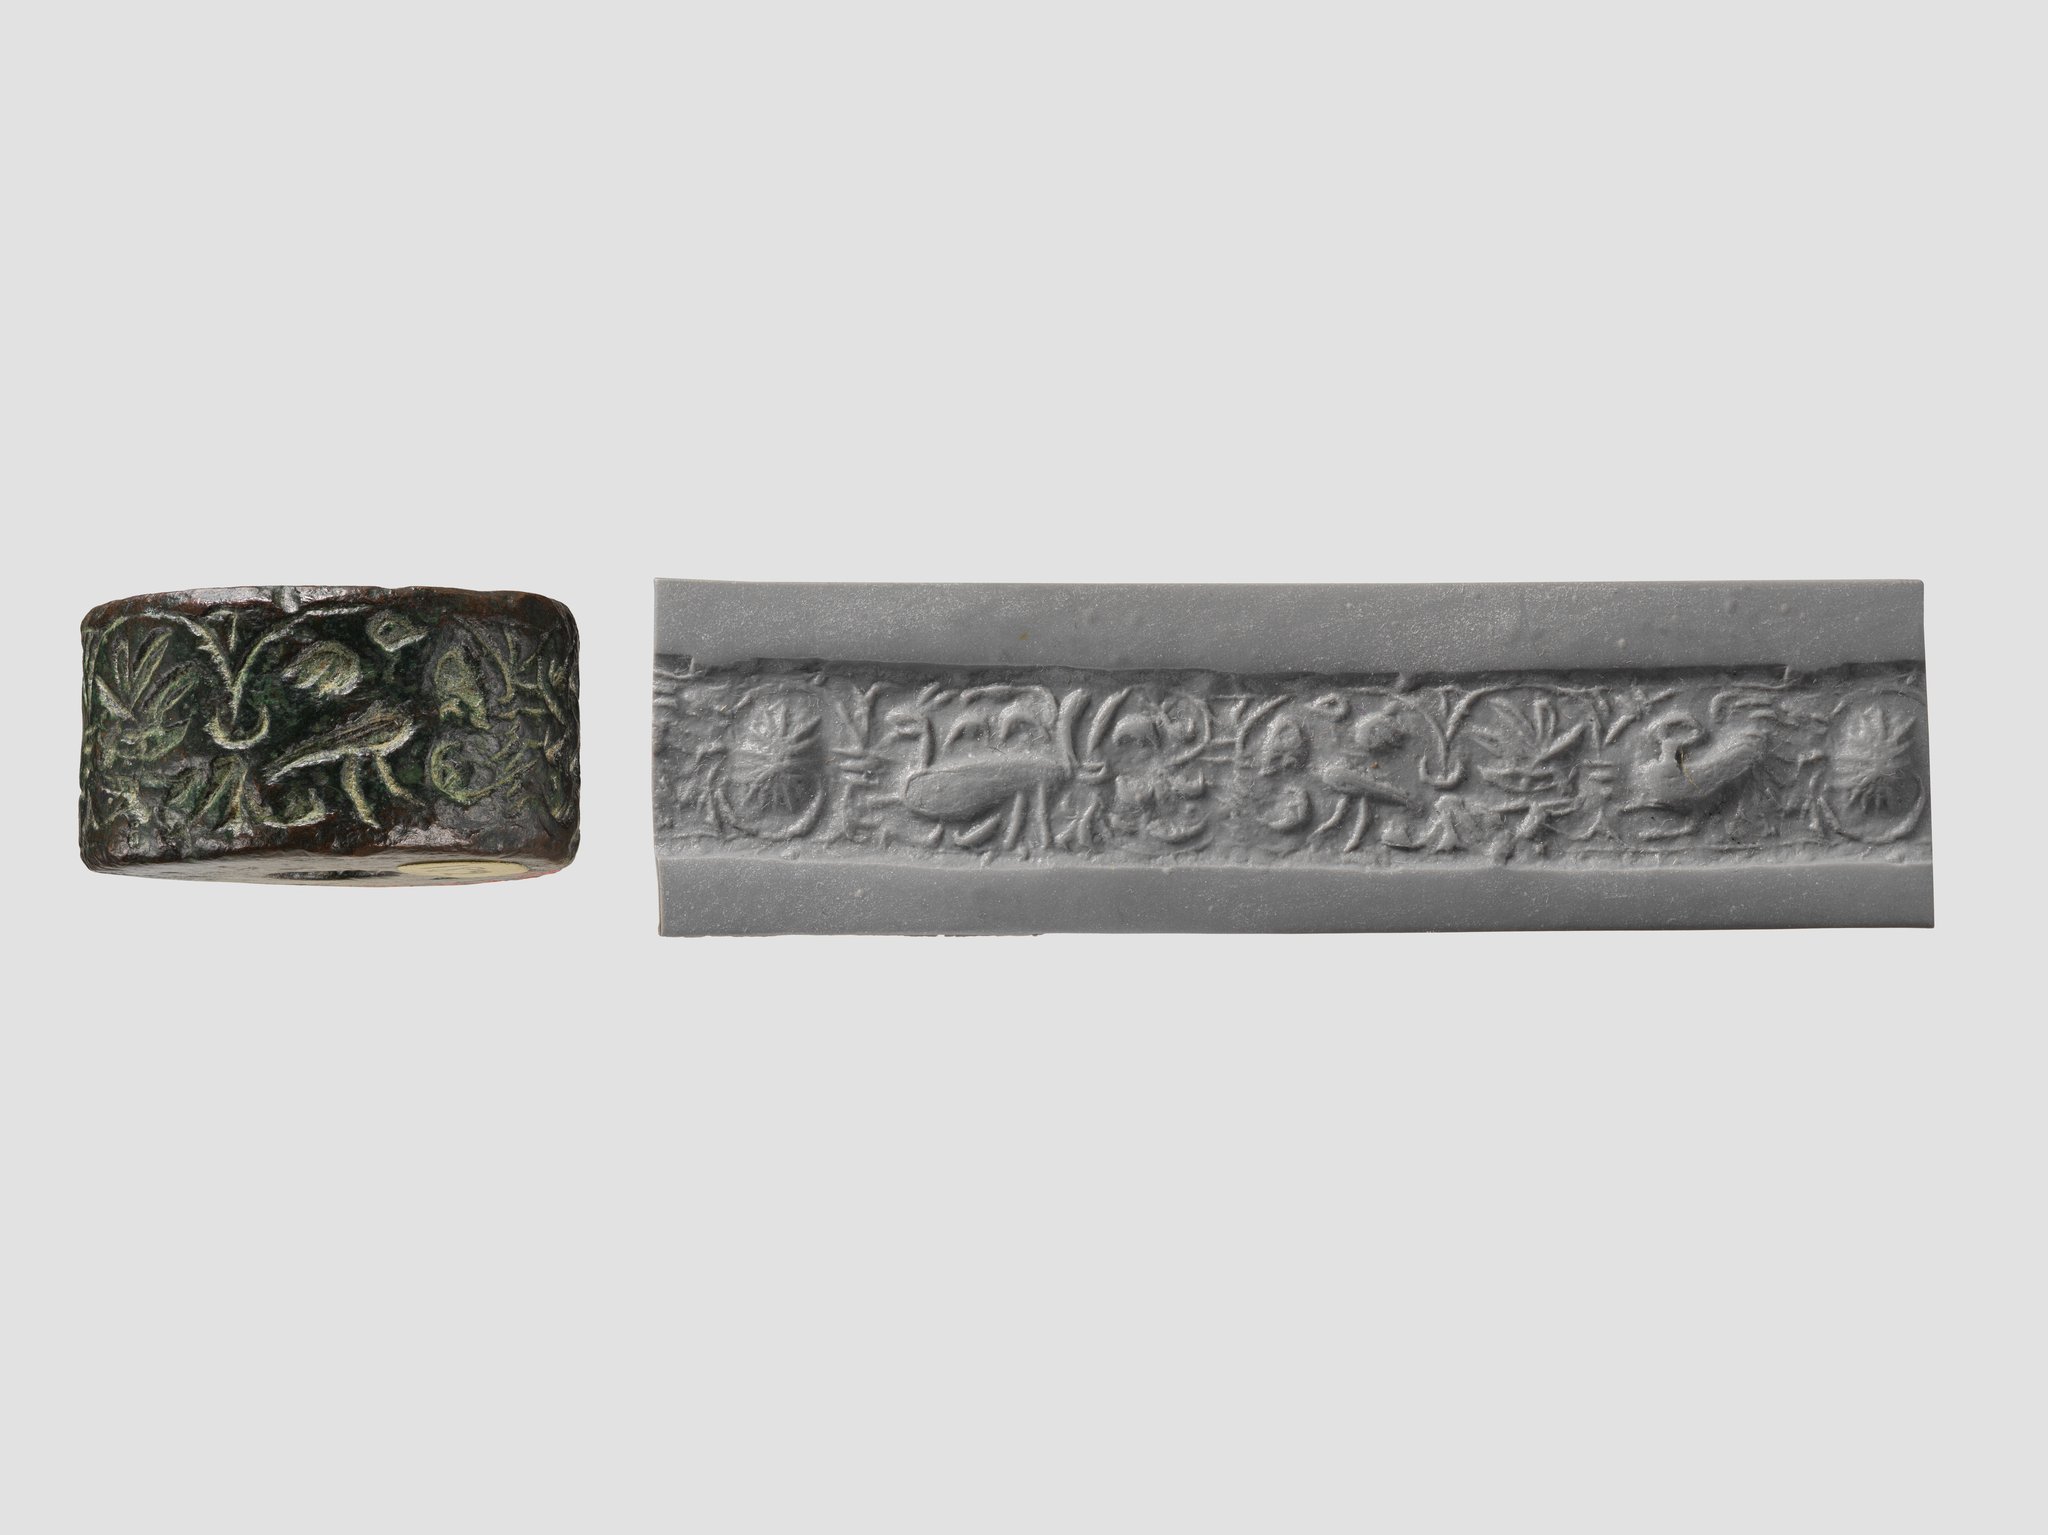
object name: cylinder seal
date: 1333-1001 BCE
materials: copper alloy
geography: levant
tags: birds